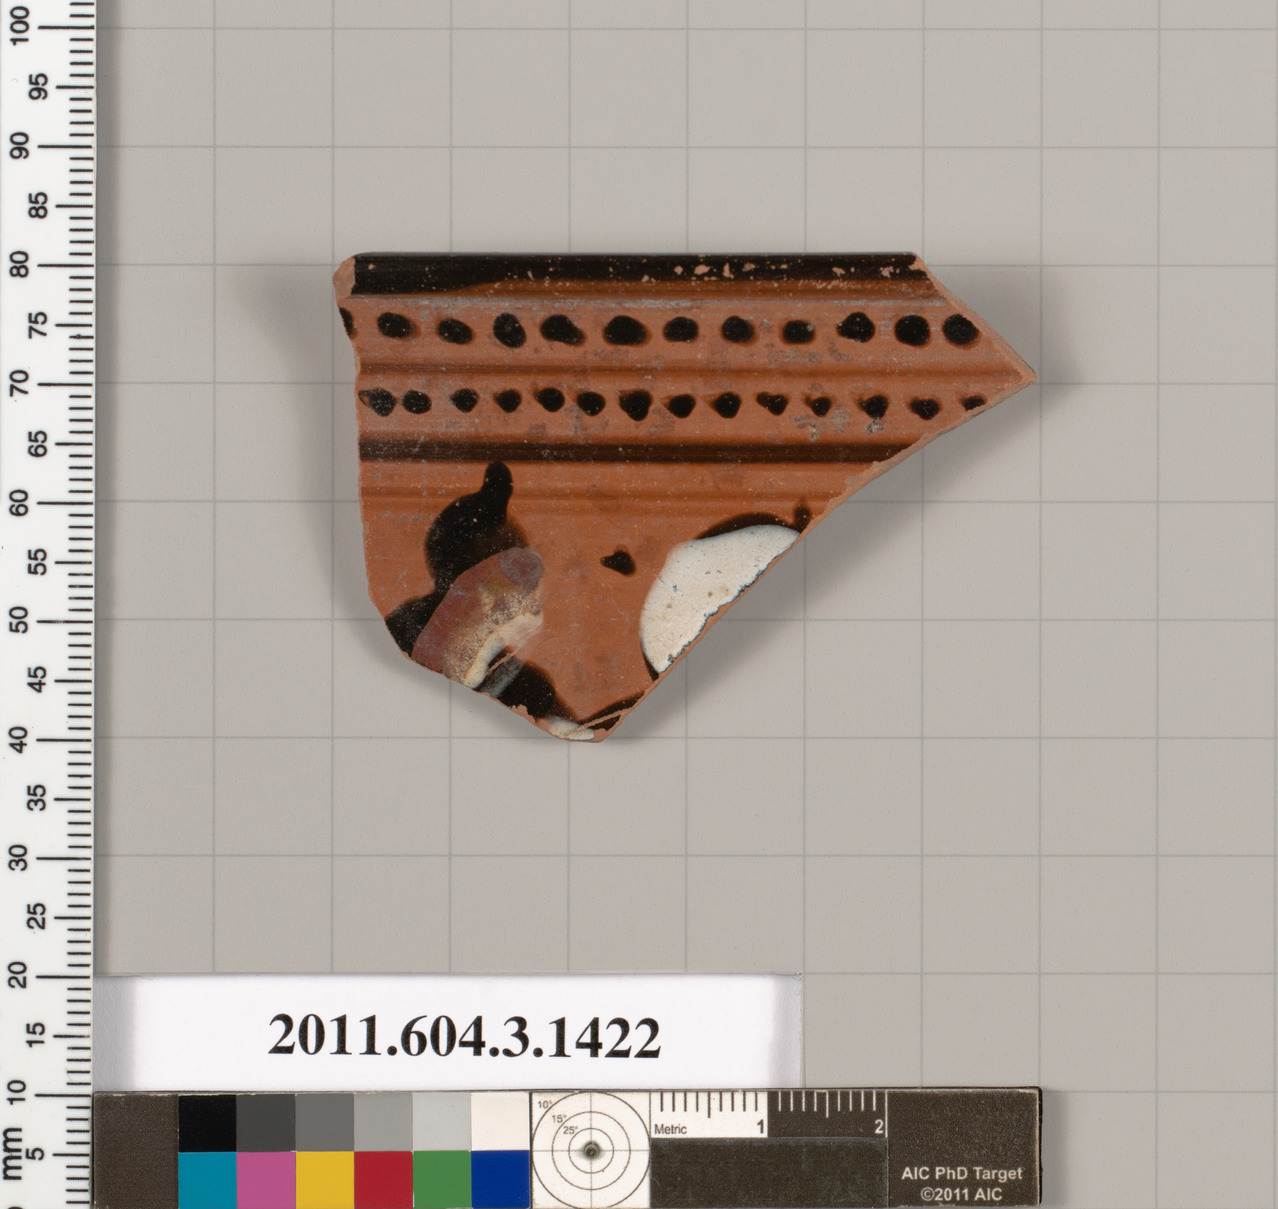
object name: skyphos fragment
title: Terracotta rim fragment of a skyphos (deep drinking cup)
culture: greek, attic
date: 500-468 BCE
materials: terracotta